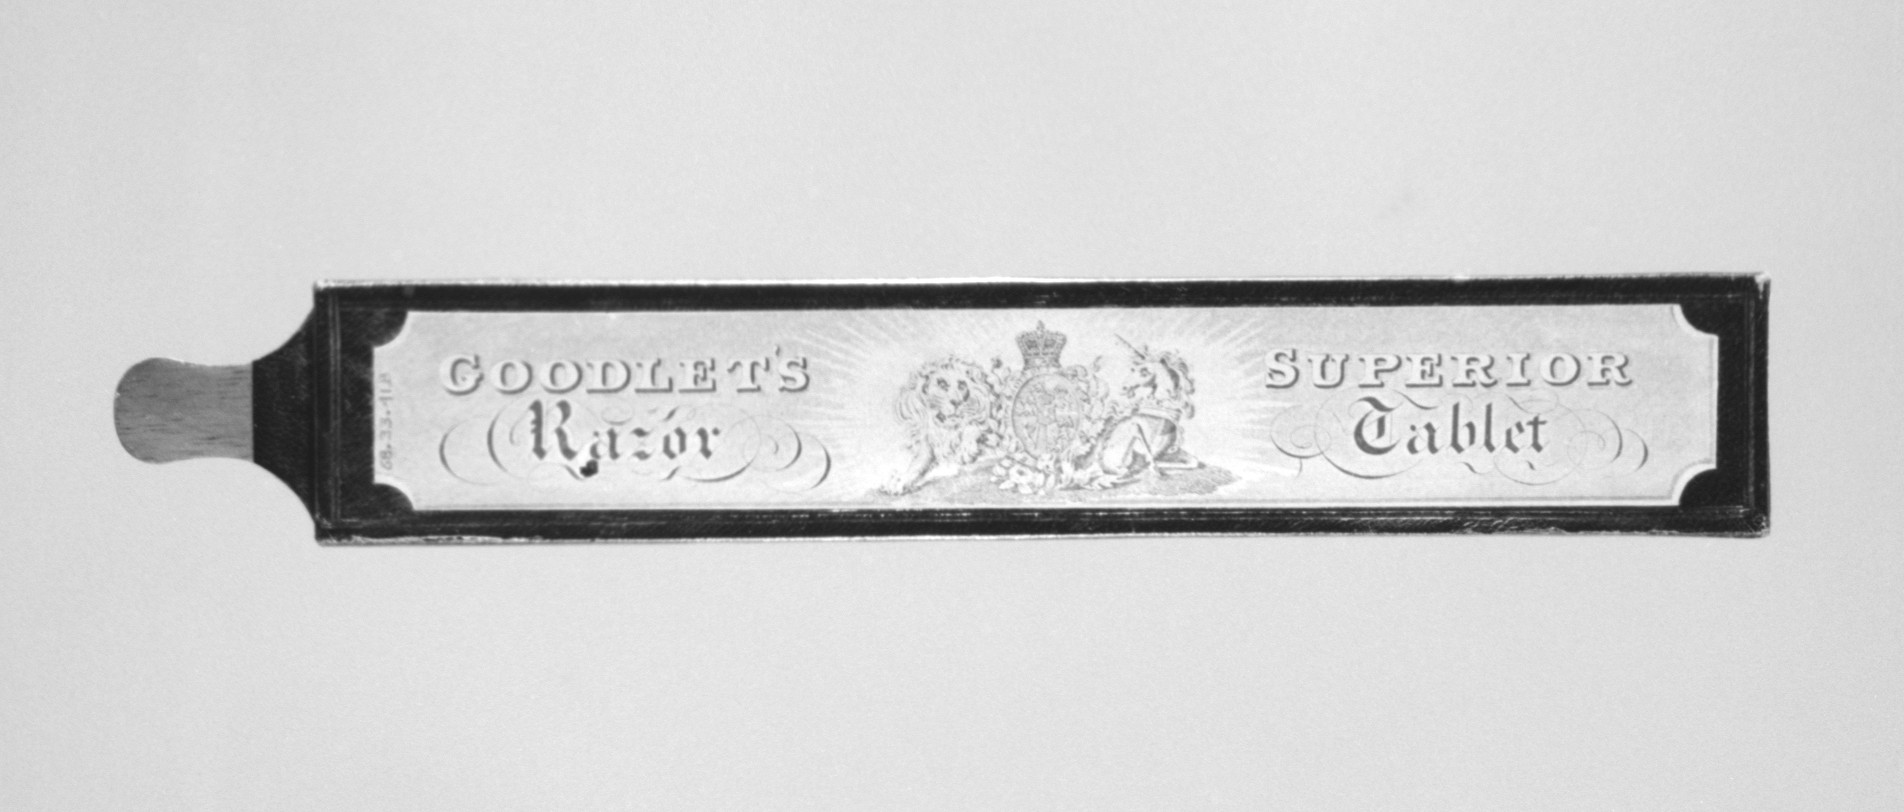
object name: hone with case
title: Hone with case (part of a set)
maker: goodlet co. (?)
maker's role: maker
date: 1848-1849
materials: cardboard, leather, wood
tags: coat of arms